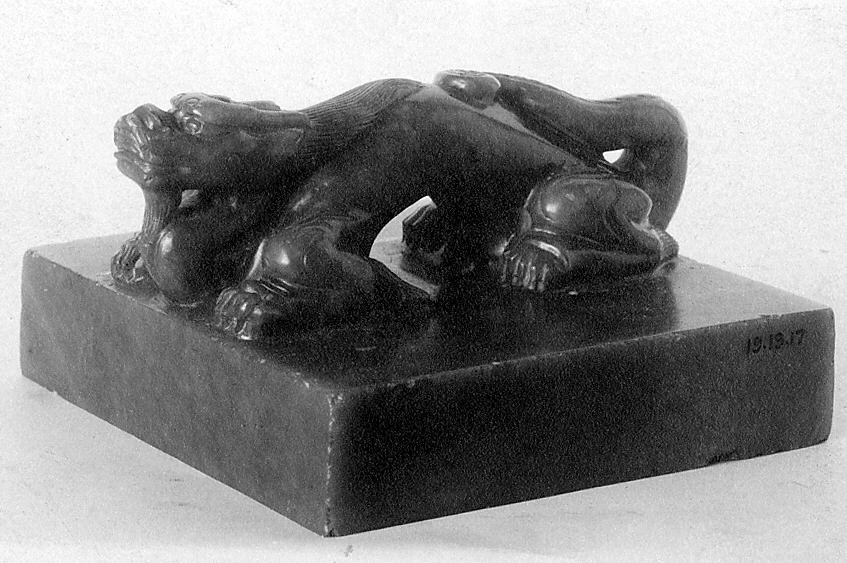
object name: seal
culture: chinese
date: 960-1279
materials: jade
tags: animals